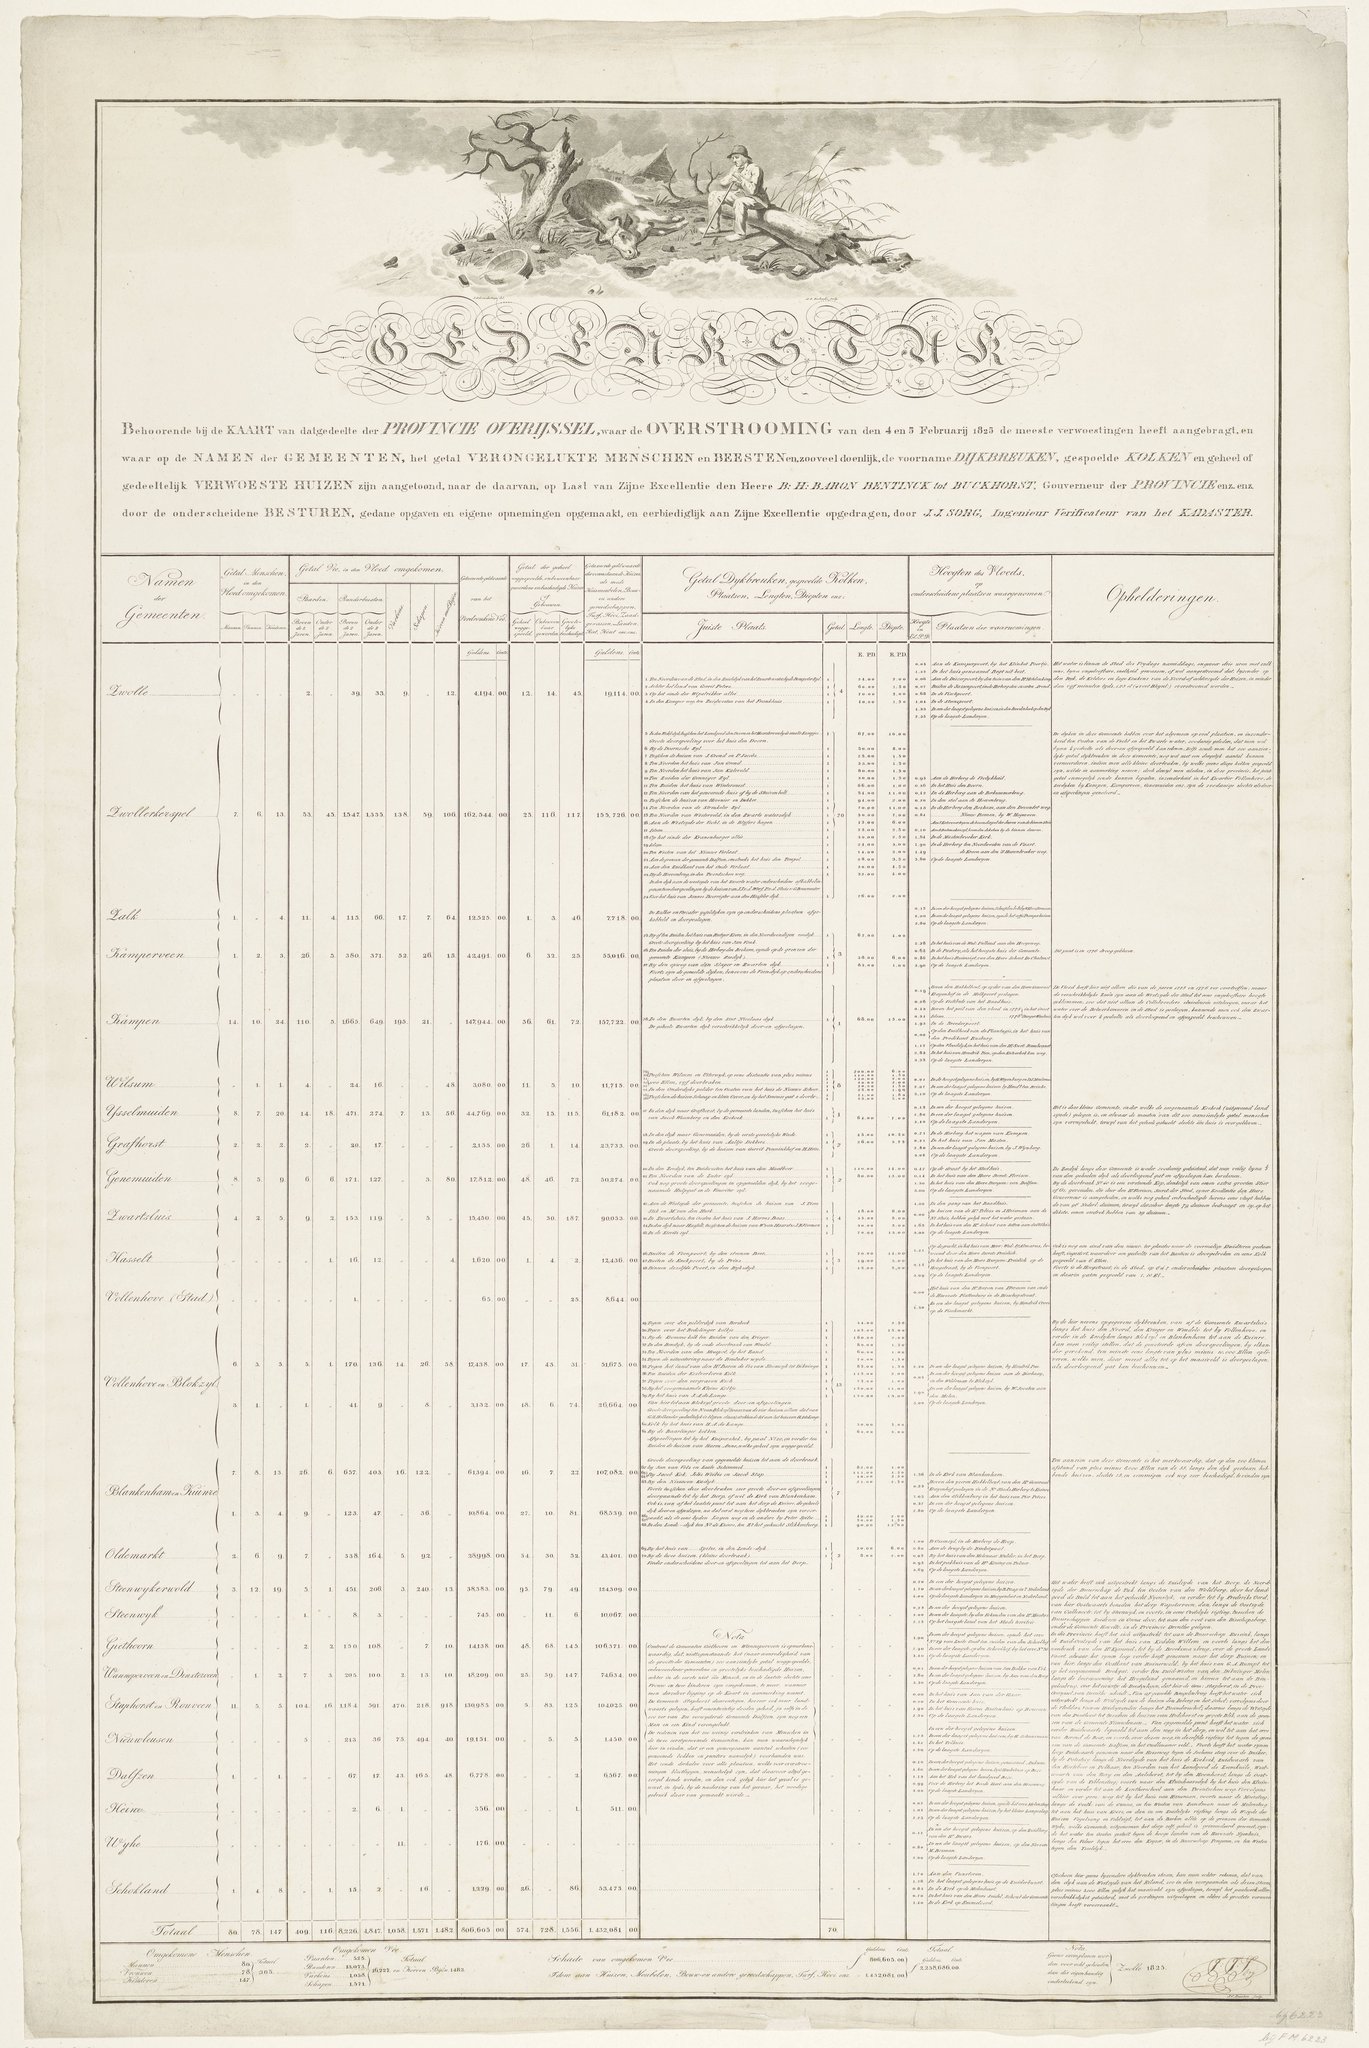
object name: print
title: Gedenkstuk. Behoorende bij de Kaart van datgedeelte der Provincie Overijssel, waar de Overstrooming van den 4 en 5 Februarij 1825 de meeste verwoestingen heeft aangebragt (...)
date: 1825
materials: paper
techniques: engraving, etching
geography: zwolle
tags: maps of separate countries or regions, flood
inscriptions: collector's mark: Lugt 2228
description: Tabel met een overzicht van de schade per gemeente in het deel van Overijssel getroffen door de watersnood van 4-5 februari 1825. Bevat ook een lijst van de voornaamste dijkbreuken en de hoogtes die het water heeft bereikt. Bovenaan een boer zittend bij verdronken vee en verwoeste boerderij. Rechtsonderaan de handtekening van de ingenieur J.J. Sorg. Behoort bij de kaart van het getroffen gebied.